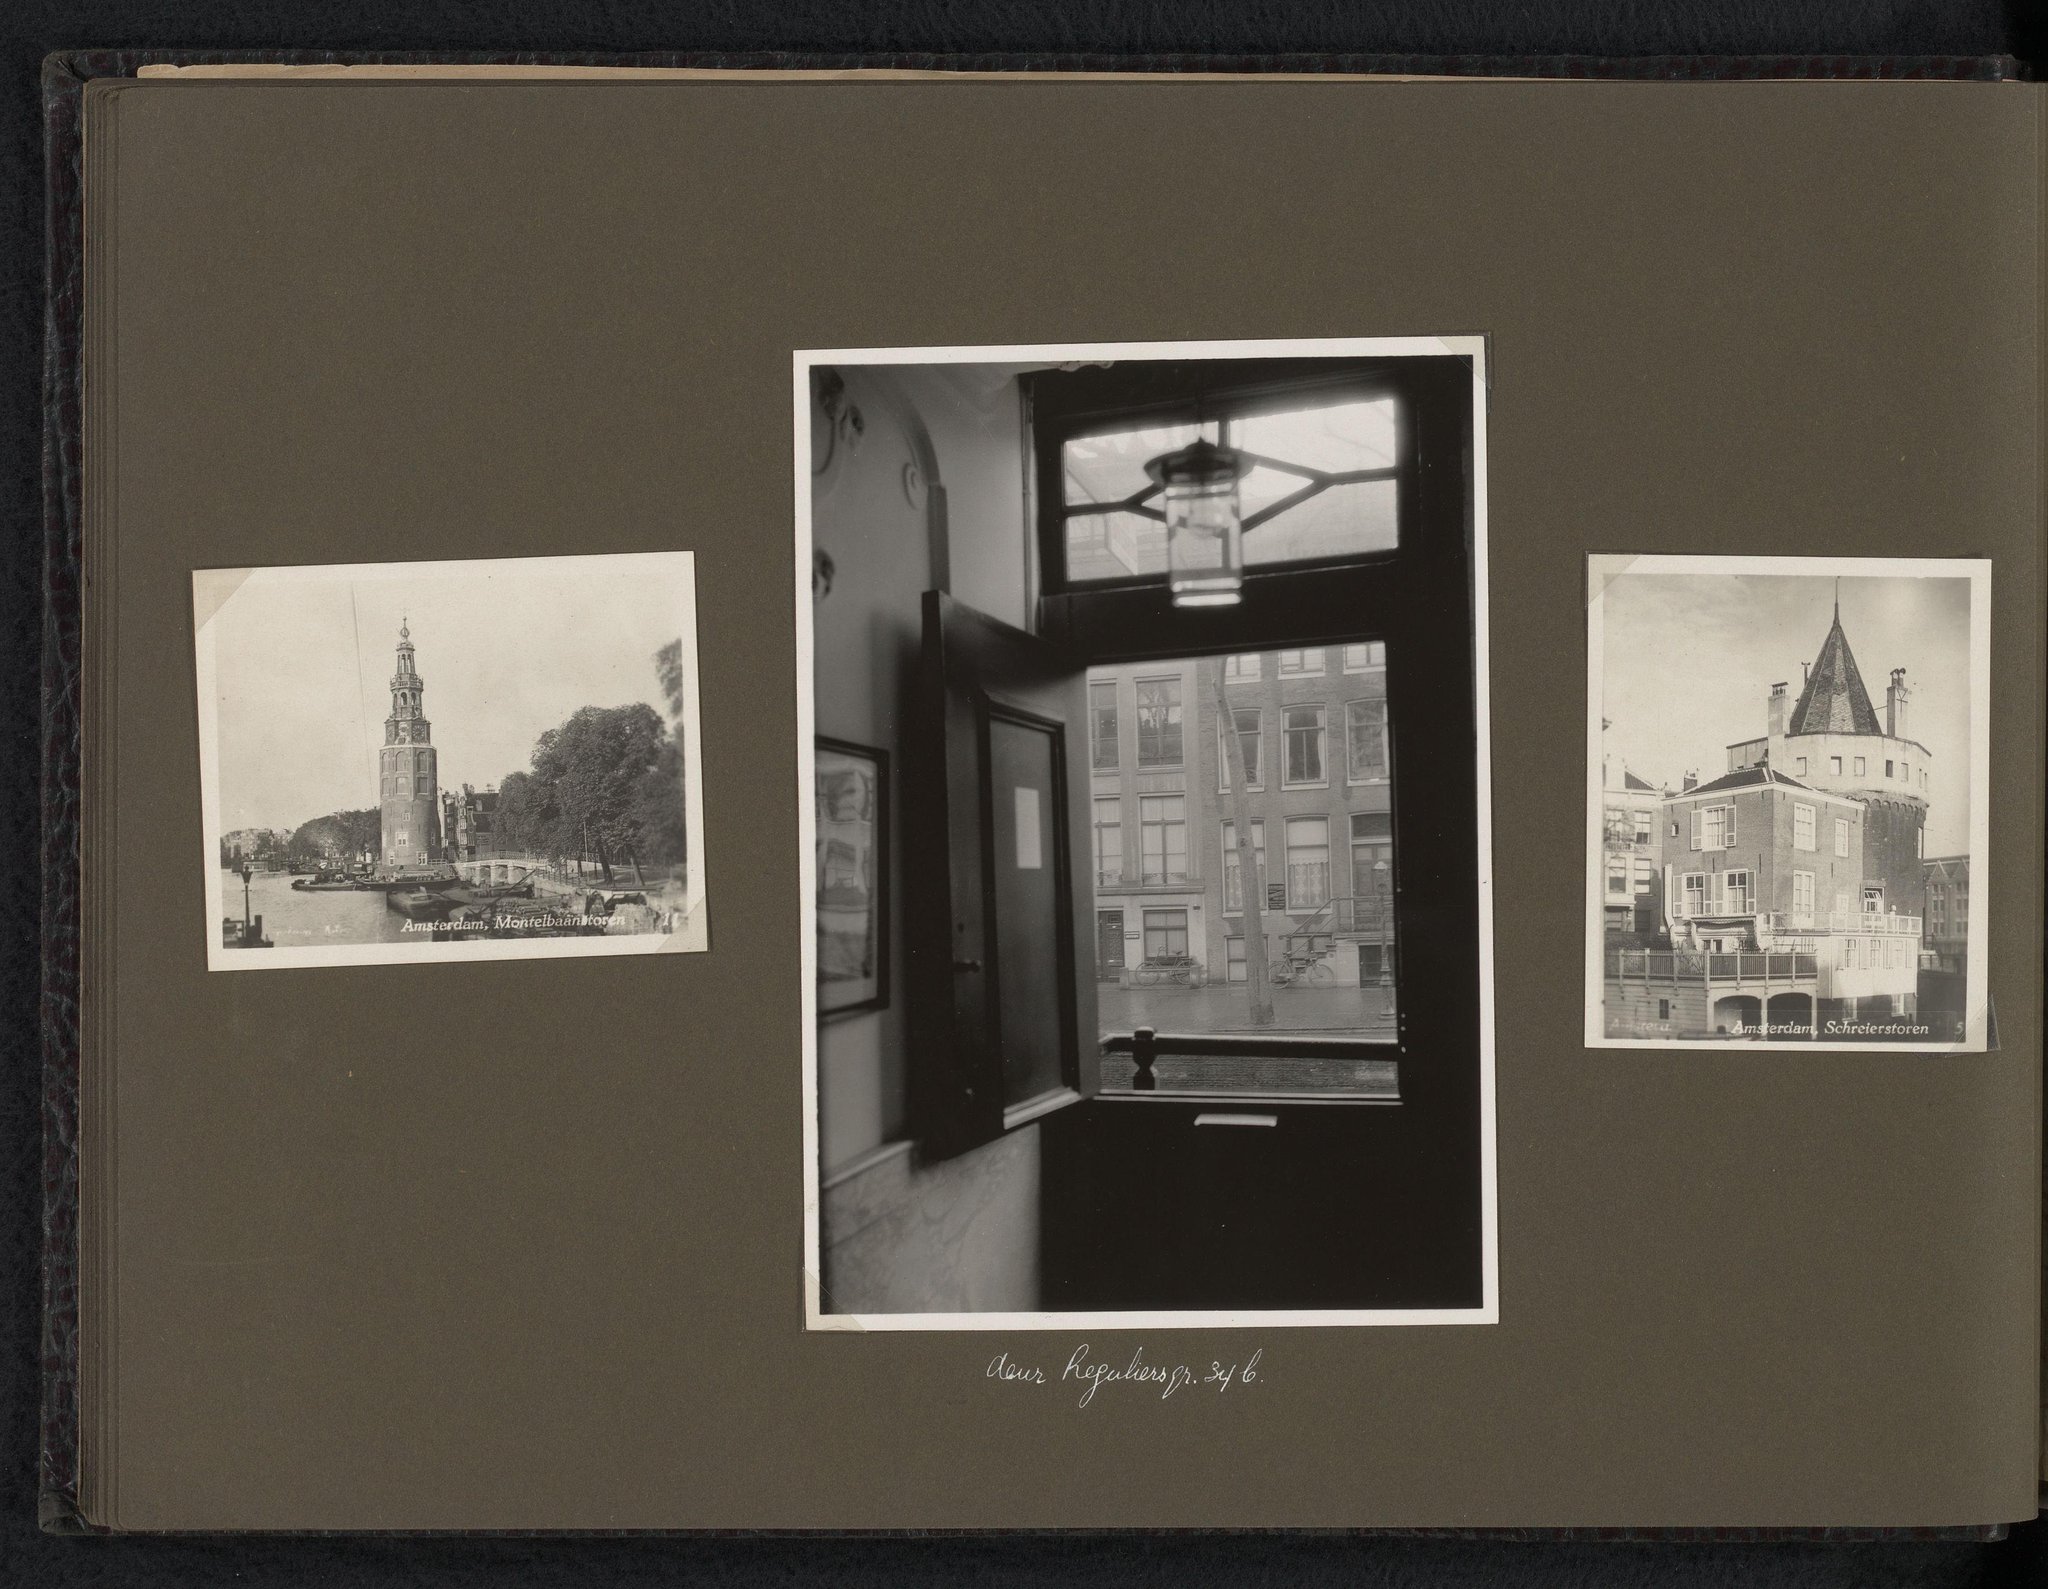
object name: photograph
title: Drie foto's vanuit het huis van Norbert van den Berg aan de Reguliersgracht 346, Amsterdam, en twee foto's van de Montelbaanstoren en de Schreierstoren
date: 1930-1931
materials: paper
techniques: gelatin silver print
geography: amsterdam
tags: tower, clock tower ~ monumental adornment, canals, waters (in city)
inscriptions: inscription: ‘deur Reguliersgr. 346’, inscription: ‘Amsterdam, Montelbaanstoren’, inscription: ‘Amsterdam, Schreierstoren’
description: Deze foto's maken deel uit van een album.